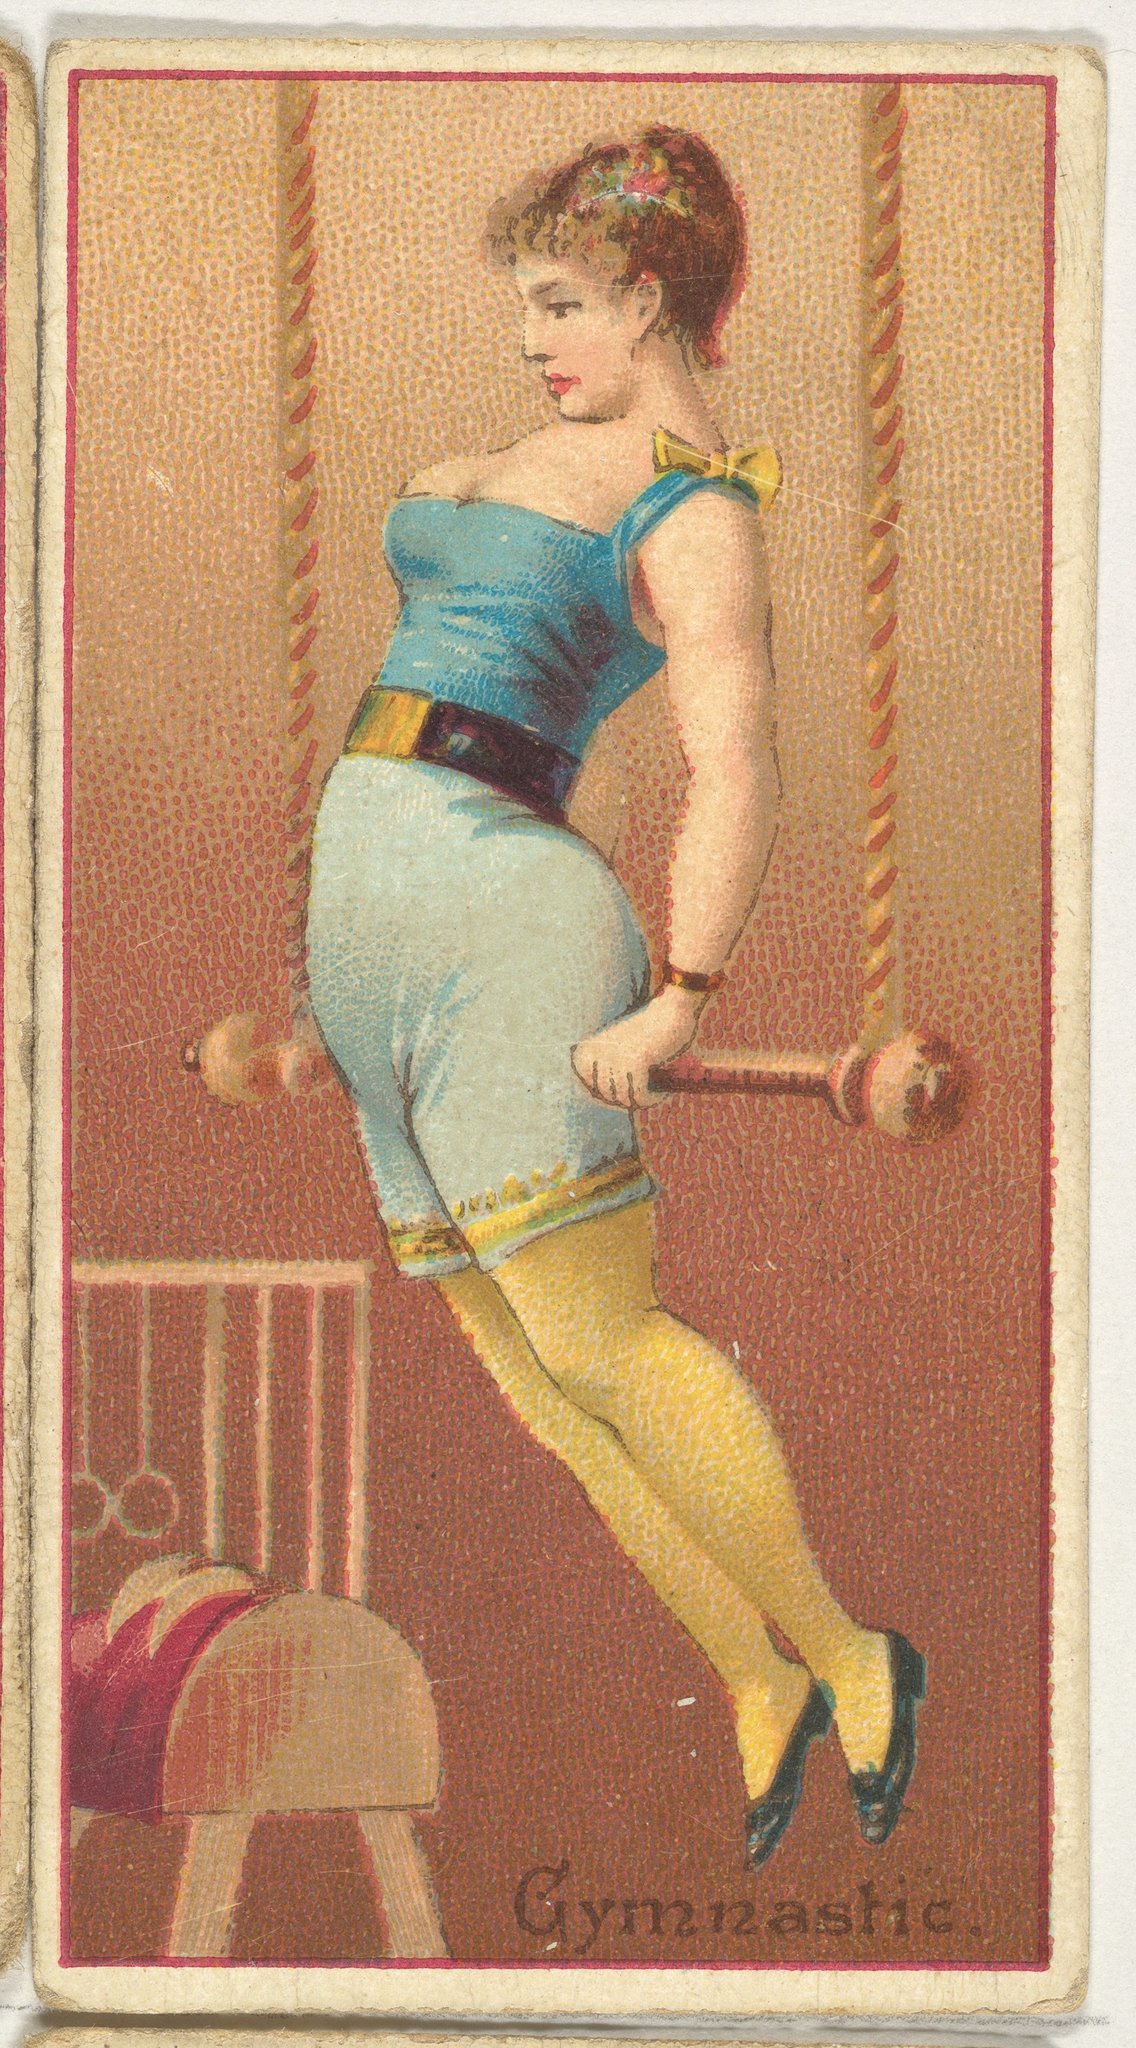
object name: print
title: Gymnastic, from the Occupations of Women series (N502) for Frishmuth's Tobacco Company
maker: frishmuth's tobacco company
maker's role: publisher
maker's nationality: american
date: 1889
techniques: color lithograph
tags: women,athletes